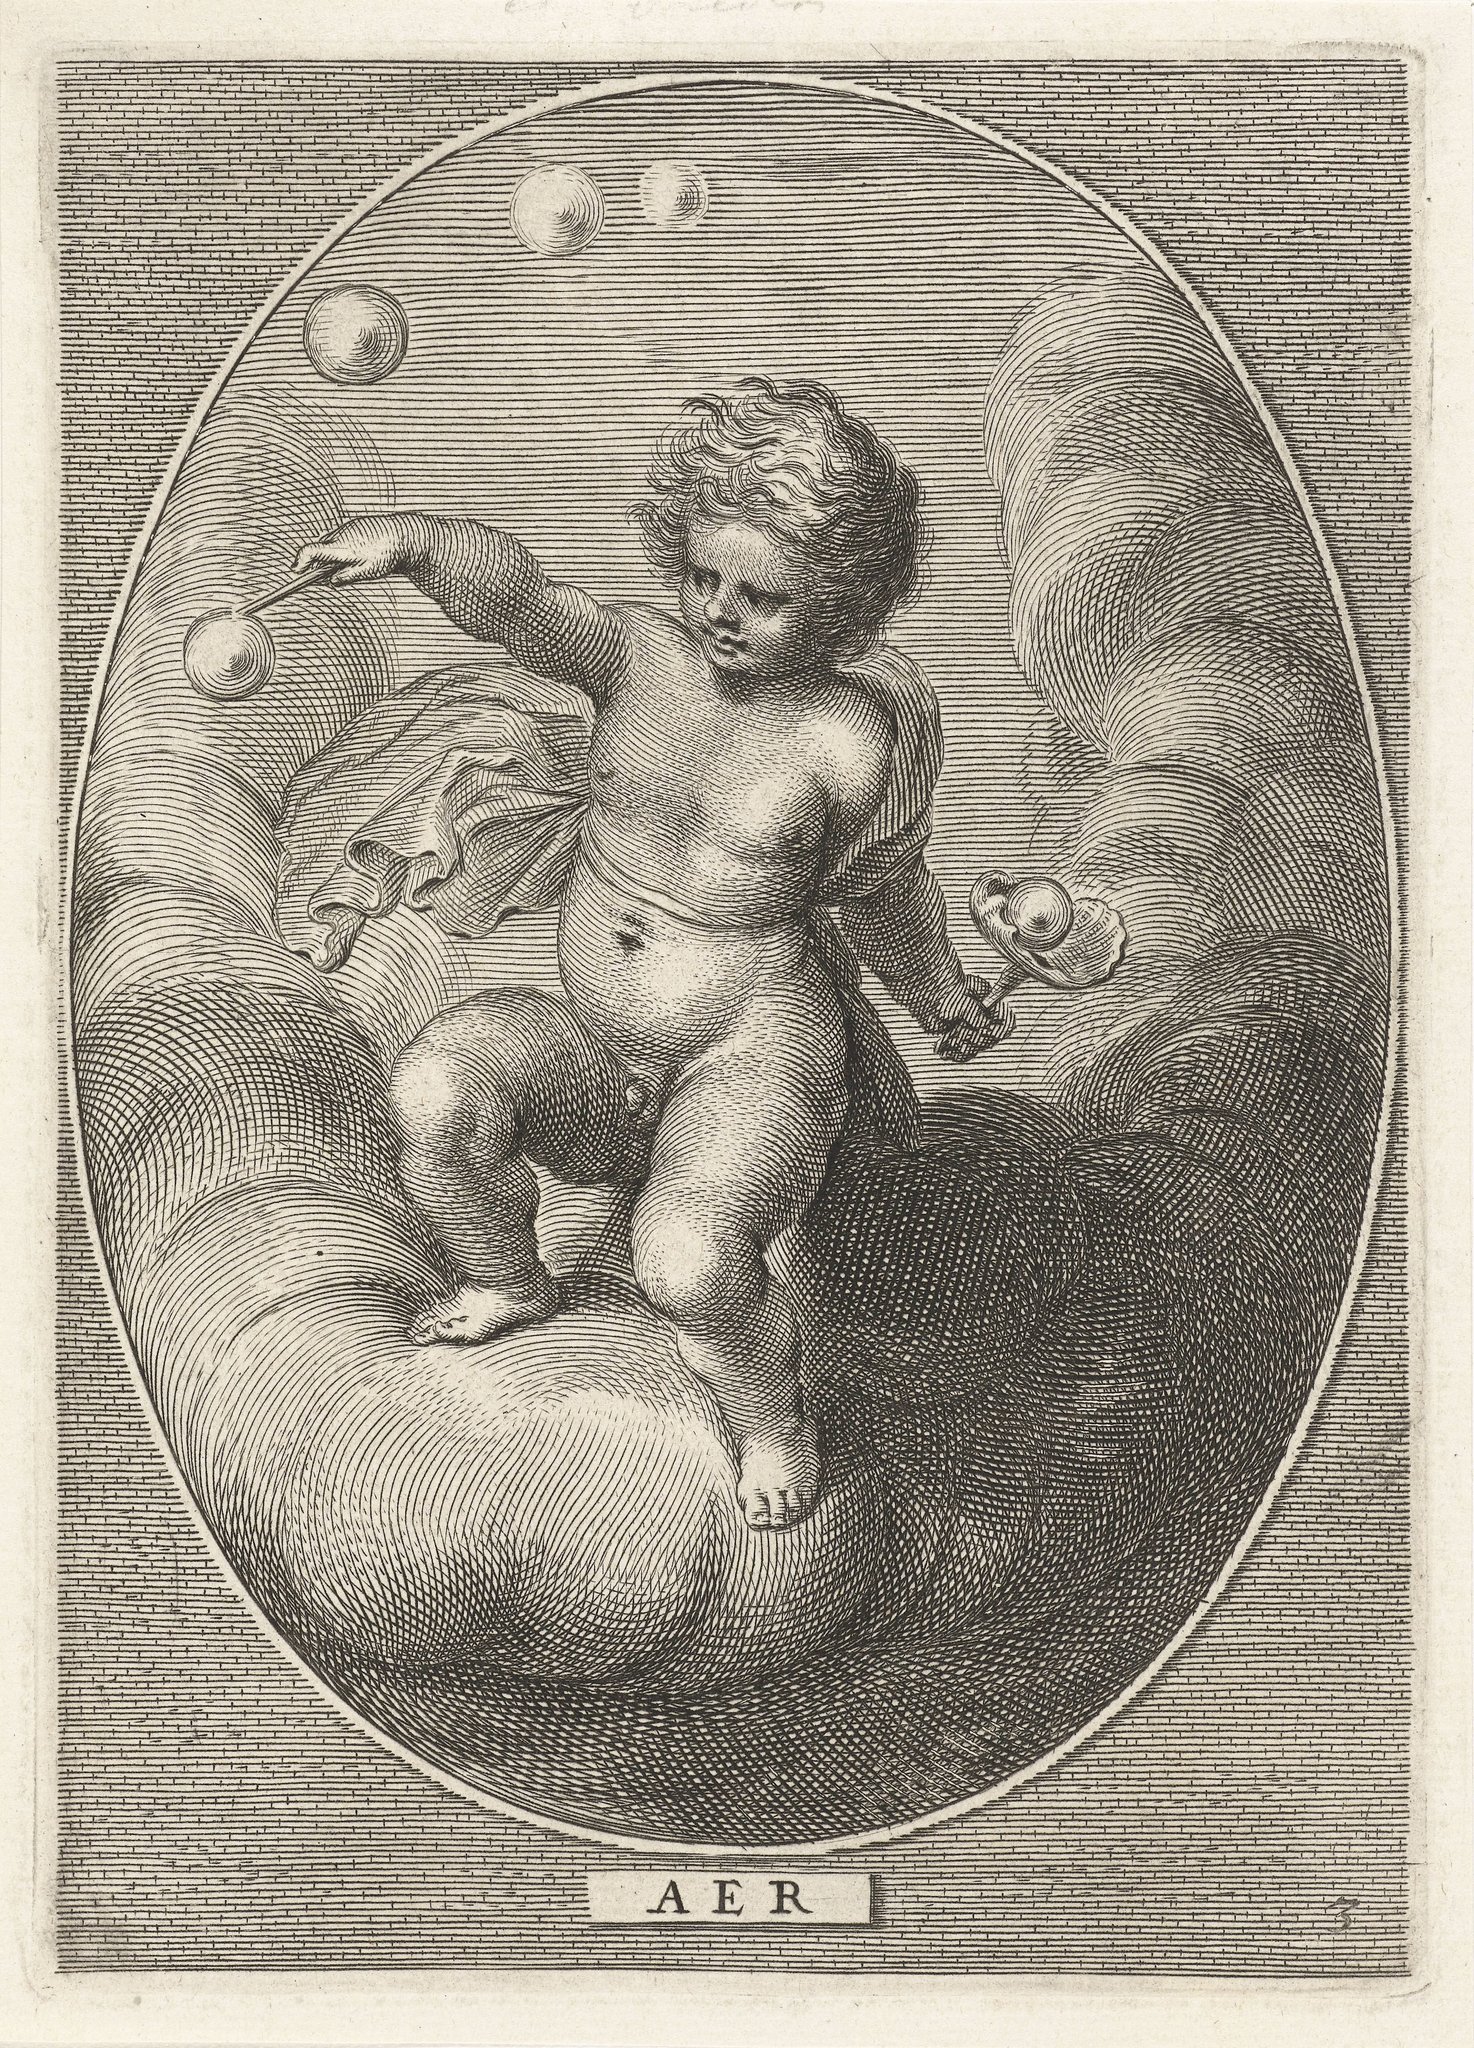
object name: print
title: Vier elementen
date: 1648-1665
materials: paper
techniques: engraving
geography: amsterdam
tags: bubble-blowing (children's games and plays), air (one of the four elements), soap-bubble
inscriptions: collector's mark: Lugt 2228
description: Prent uit serie van vier prenten met de vier elementen naar ontwerp van Abraham van Diepenbeeck.